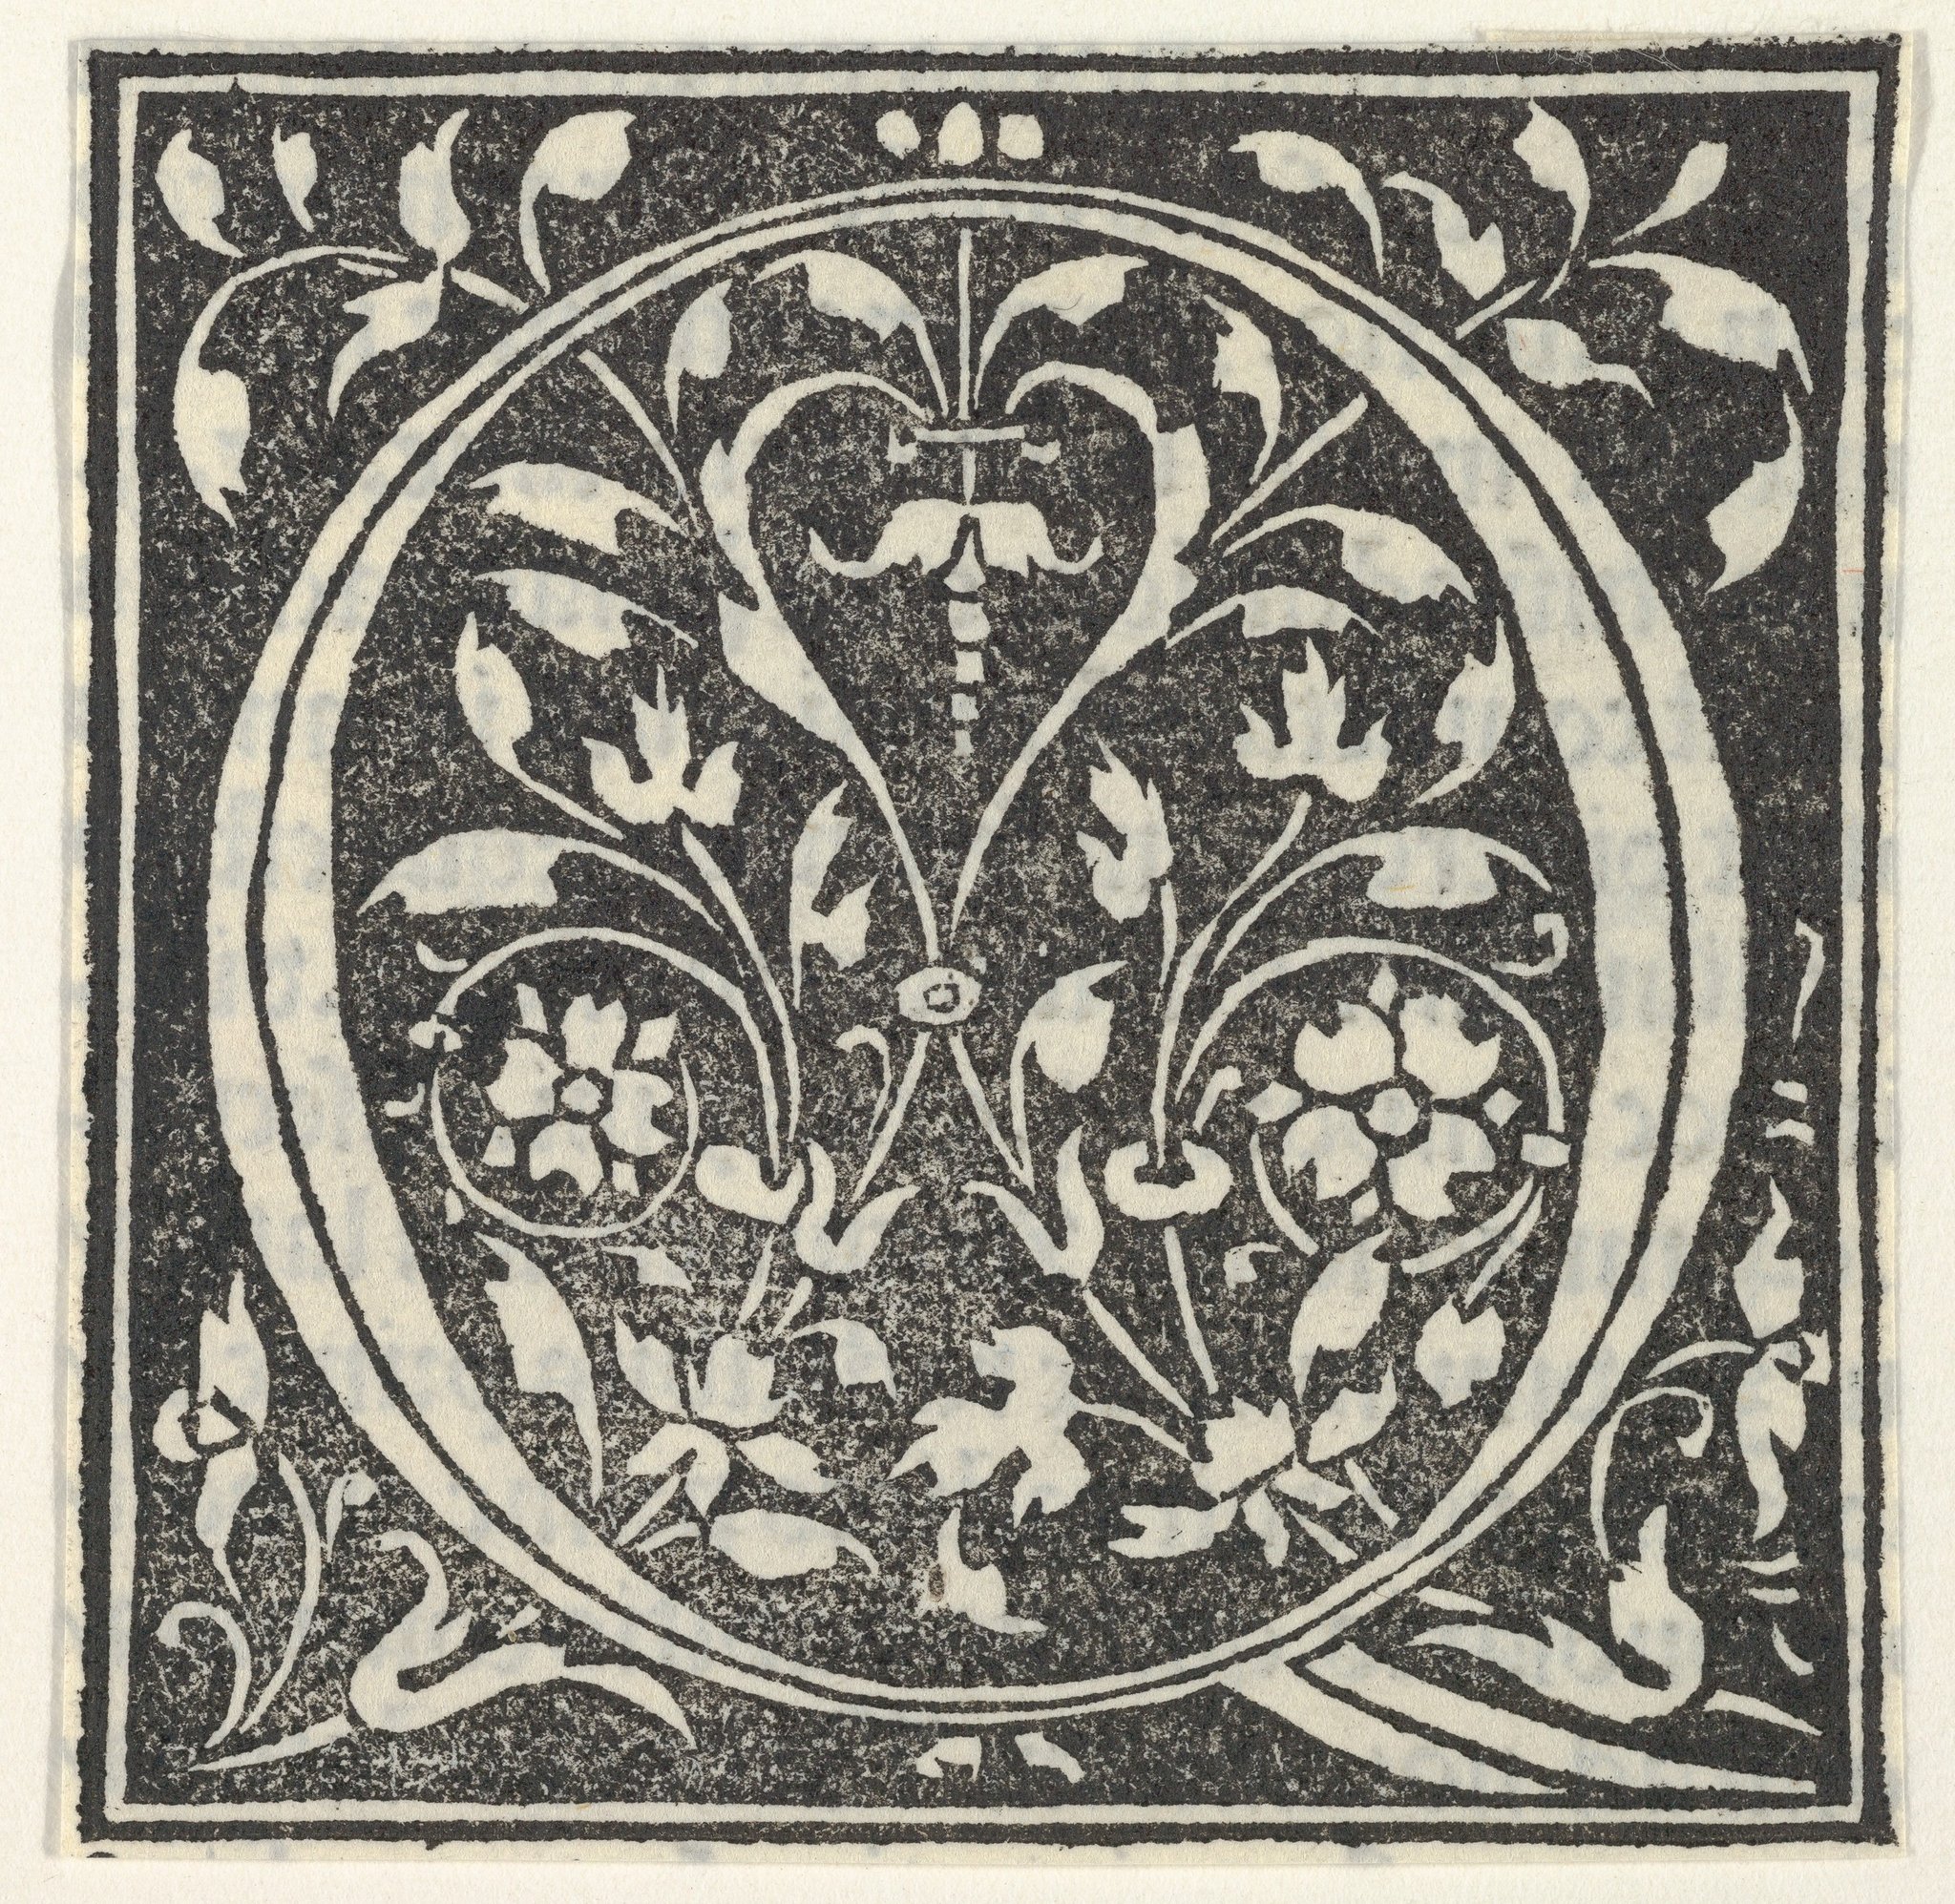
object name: print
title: Initial letter Q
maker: anonymous, italian, 15th century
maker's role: artist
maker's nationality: italian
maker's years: 1400-1500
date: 1495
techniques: woodcut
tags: flowers,leaves